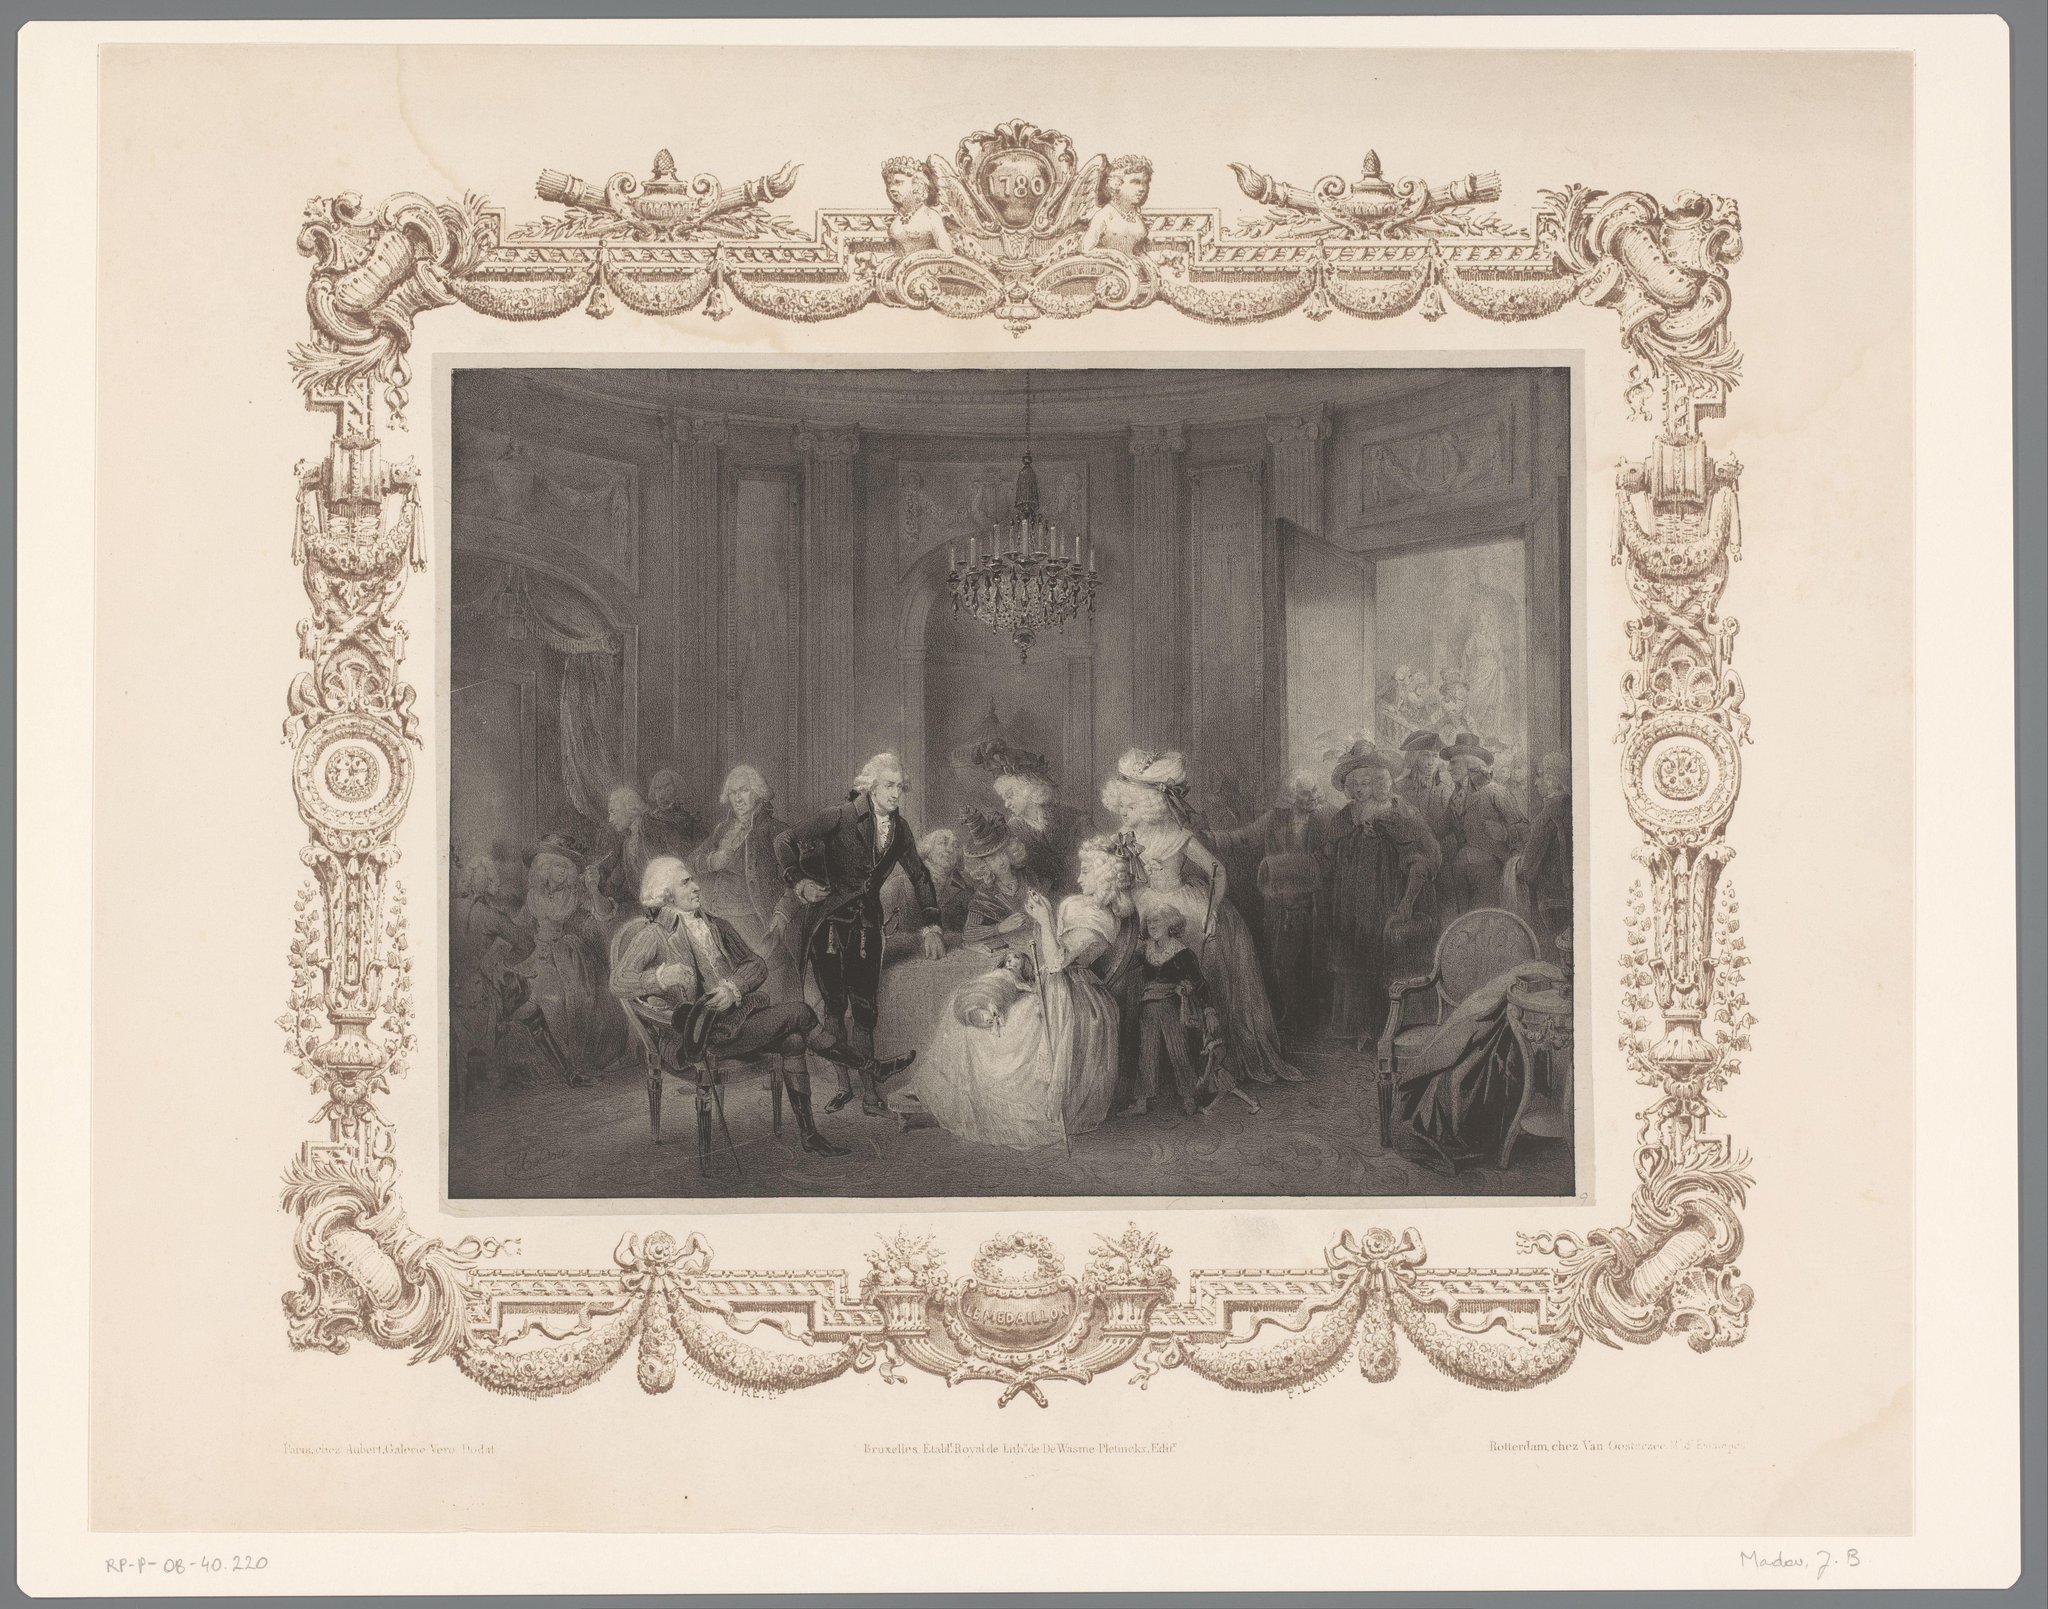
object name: print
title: Fysionomie van de welgestelden in Europa van de vijftiende tot en met de negentiende eeuw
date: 1835-1837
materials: paper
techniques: lithograph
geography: paris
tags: visiting; receiving guests; elegant company, pendant, trinket, 'breloque', interior of the house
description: De voorstelling is vervaardigd door Madou, de omlijsting door Paulus Lauters en Philastre.